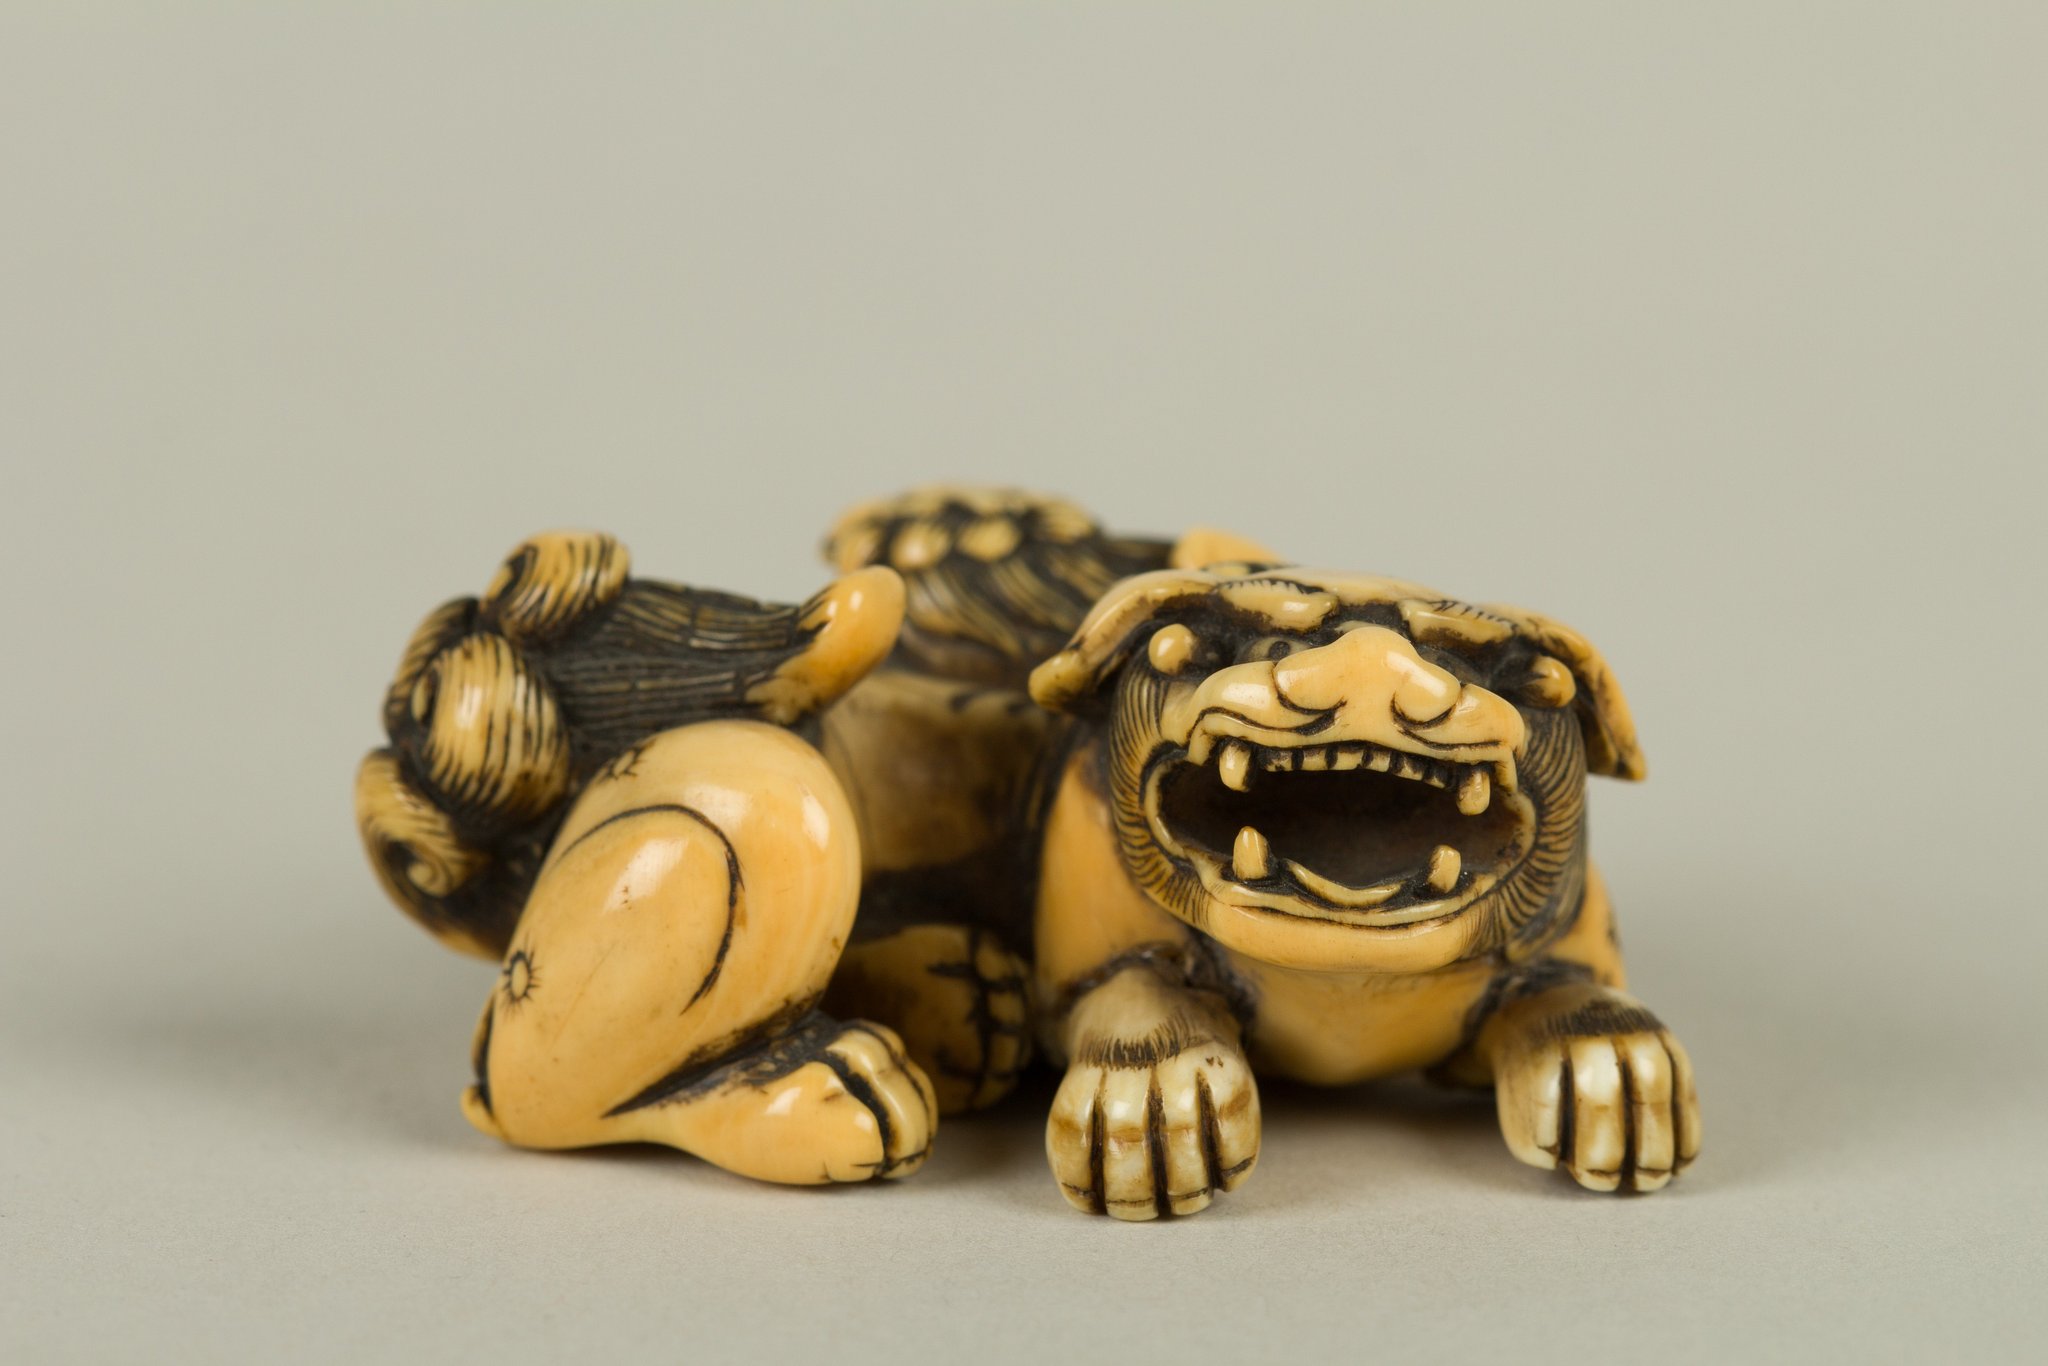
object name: netsuke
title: Netsuke of Lion with a Cub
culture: japanese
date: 1801-1900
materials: ivory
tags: lions